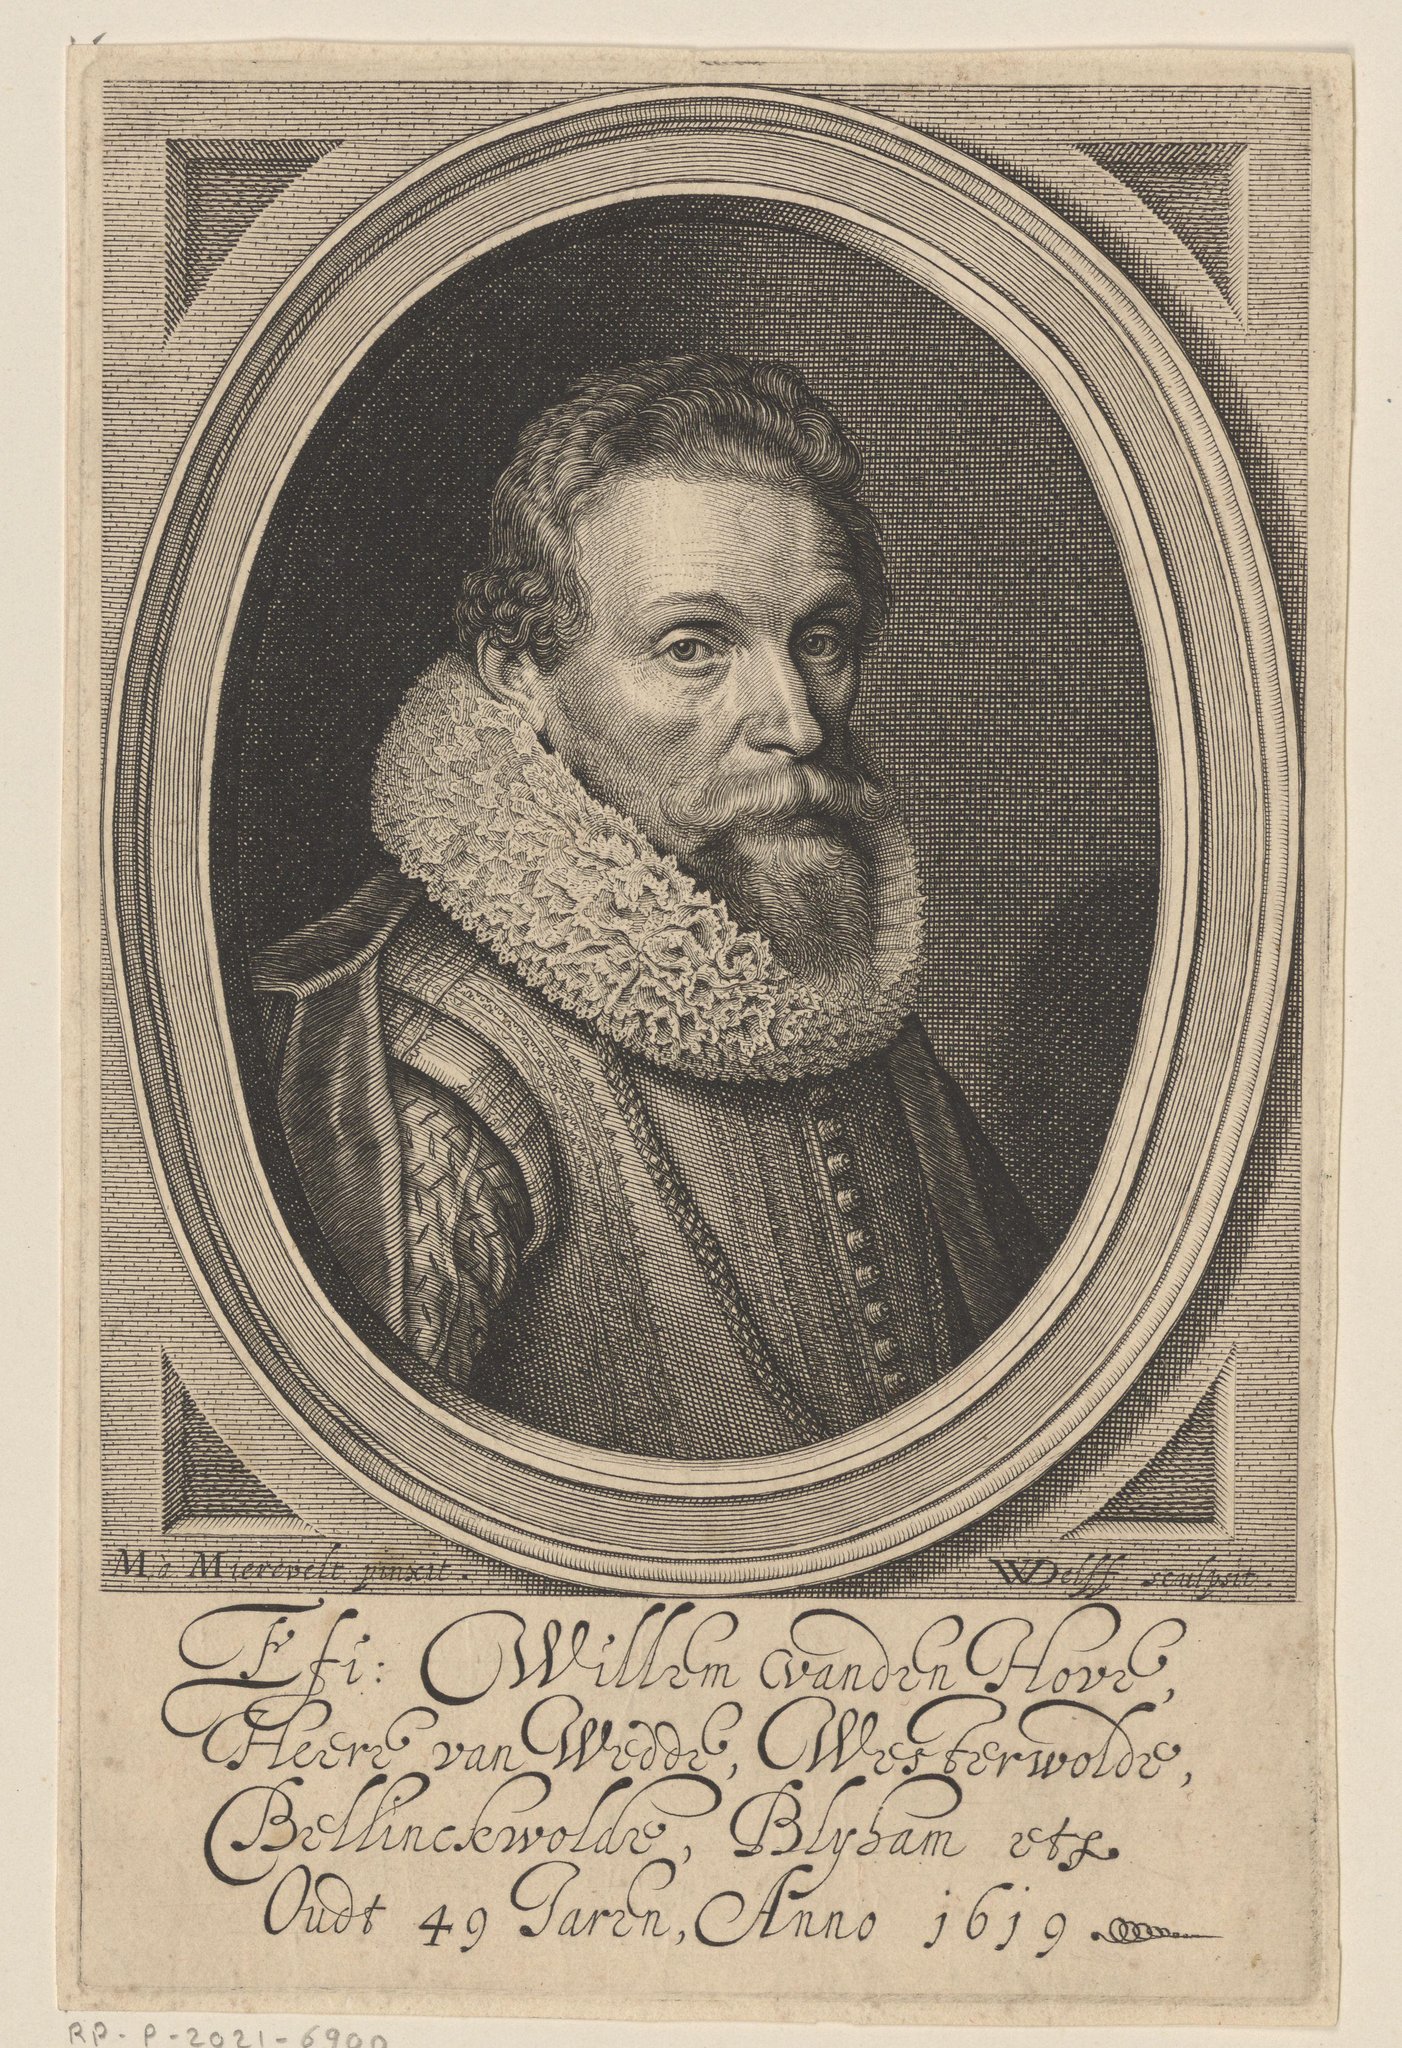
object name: print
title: Portret van Willem van den Hove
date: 1619-1638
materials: paper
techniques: engraving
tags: historical persons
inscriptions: collector's mark: Lugt 2228